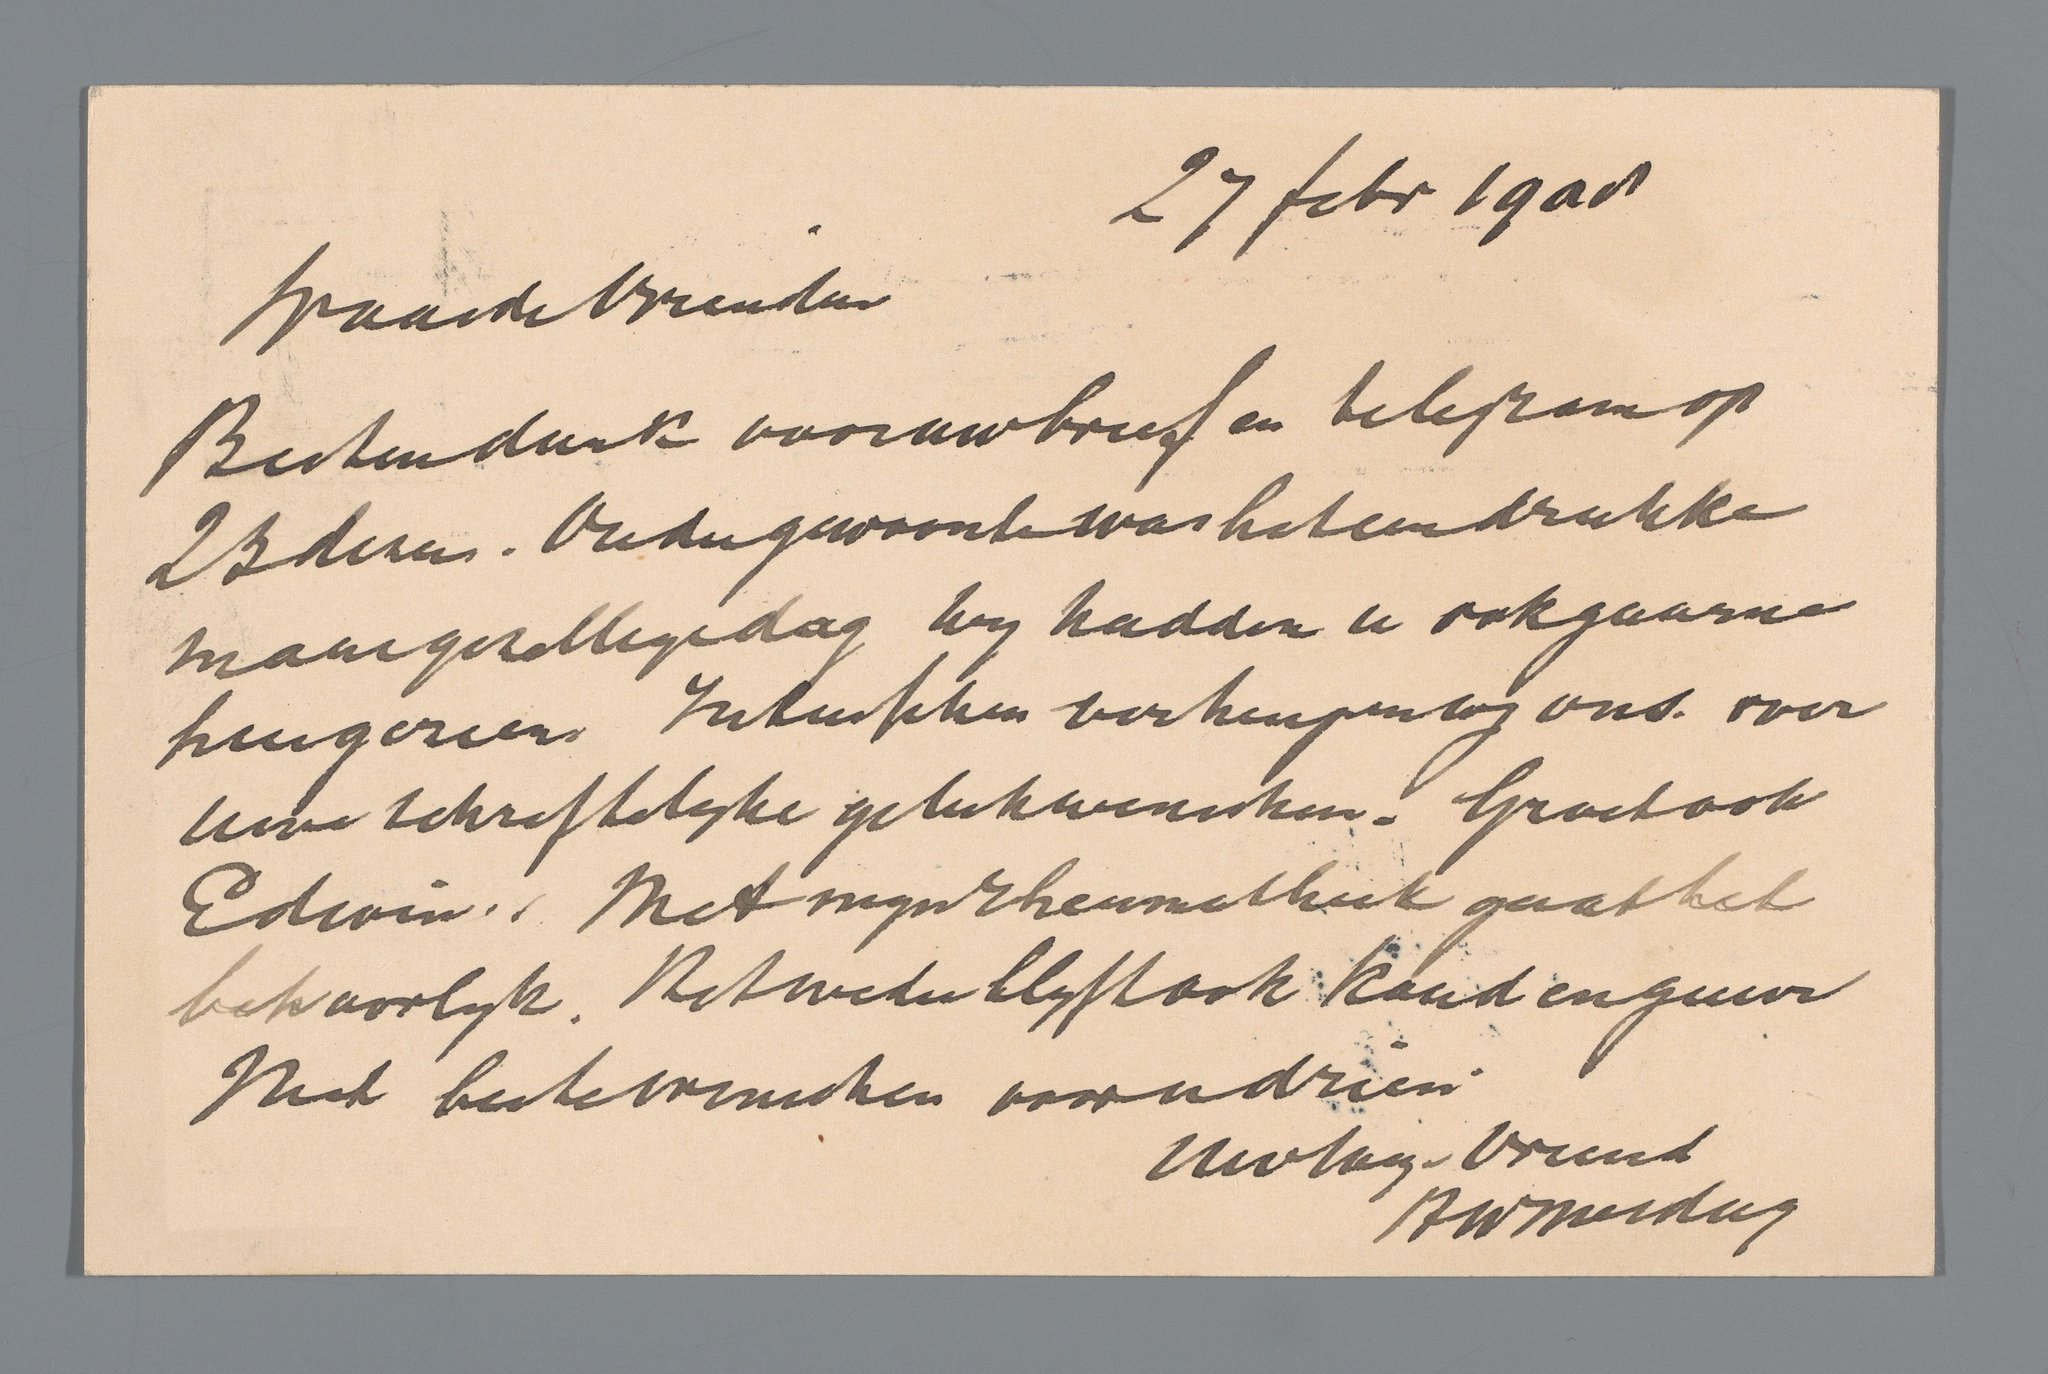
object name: postcard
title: Briefkaart aan Max Behrend en Johanna Behrend-Croiset van der Kop in Mainz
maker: hendrik willem mesdag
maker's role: draughtsman, painter, print maker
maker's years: 1831-1915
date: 1908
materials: cardboard, ink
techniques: writing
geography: netherlands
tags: the hague, utrecht, painter, draughtsman, johanna behrend-croiset van der kop